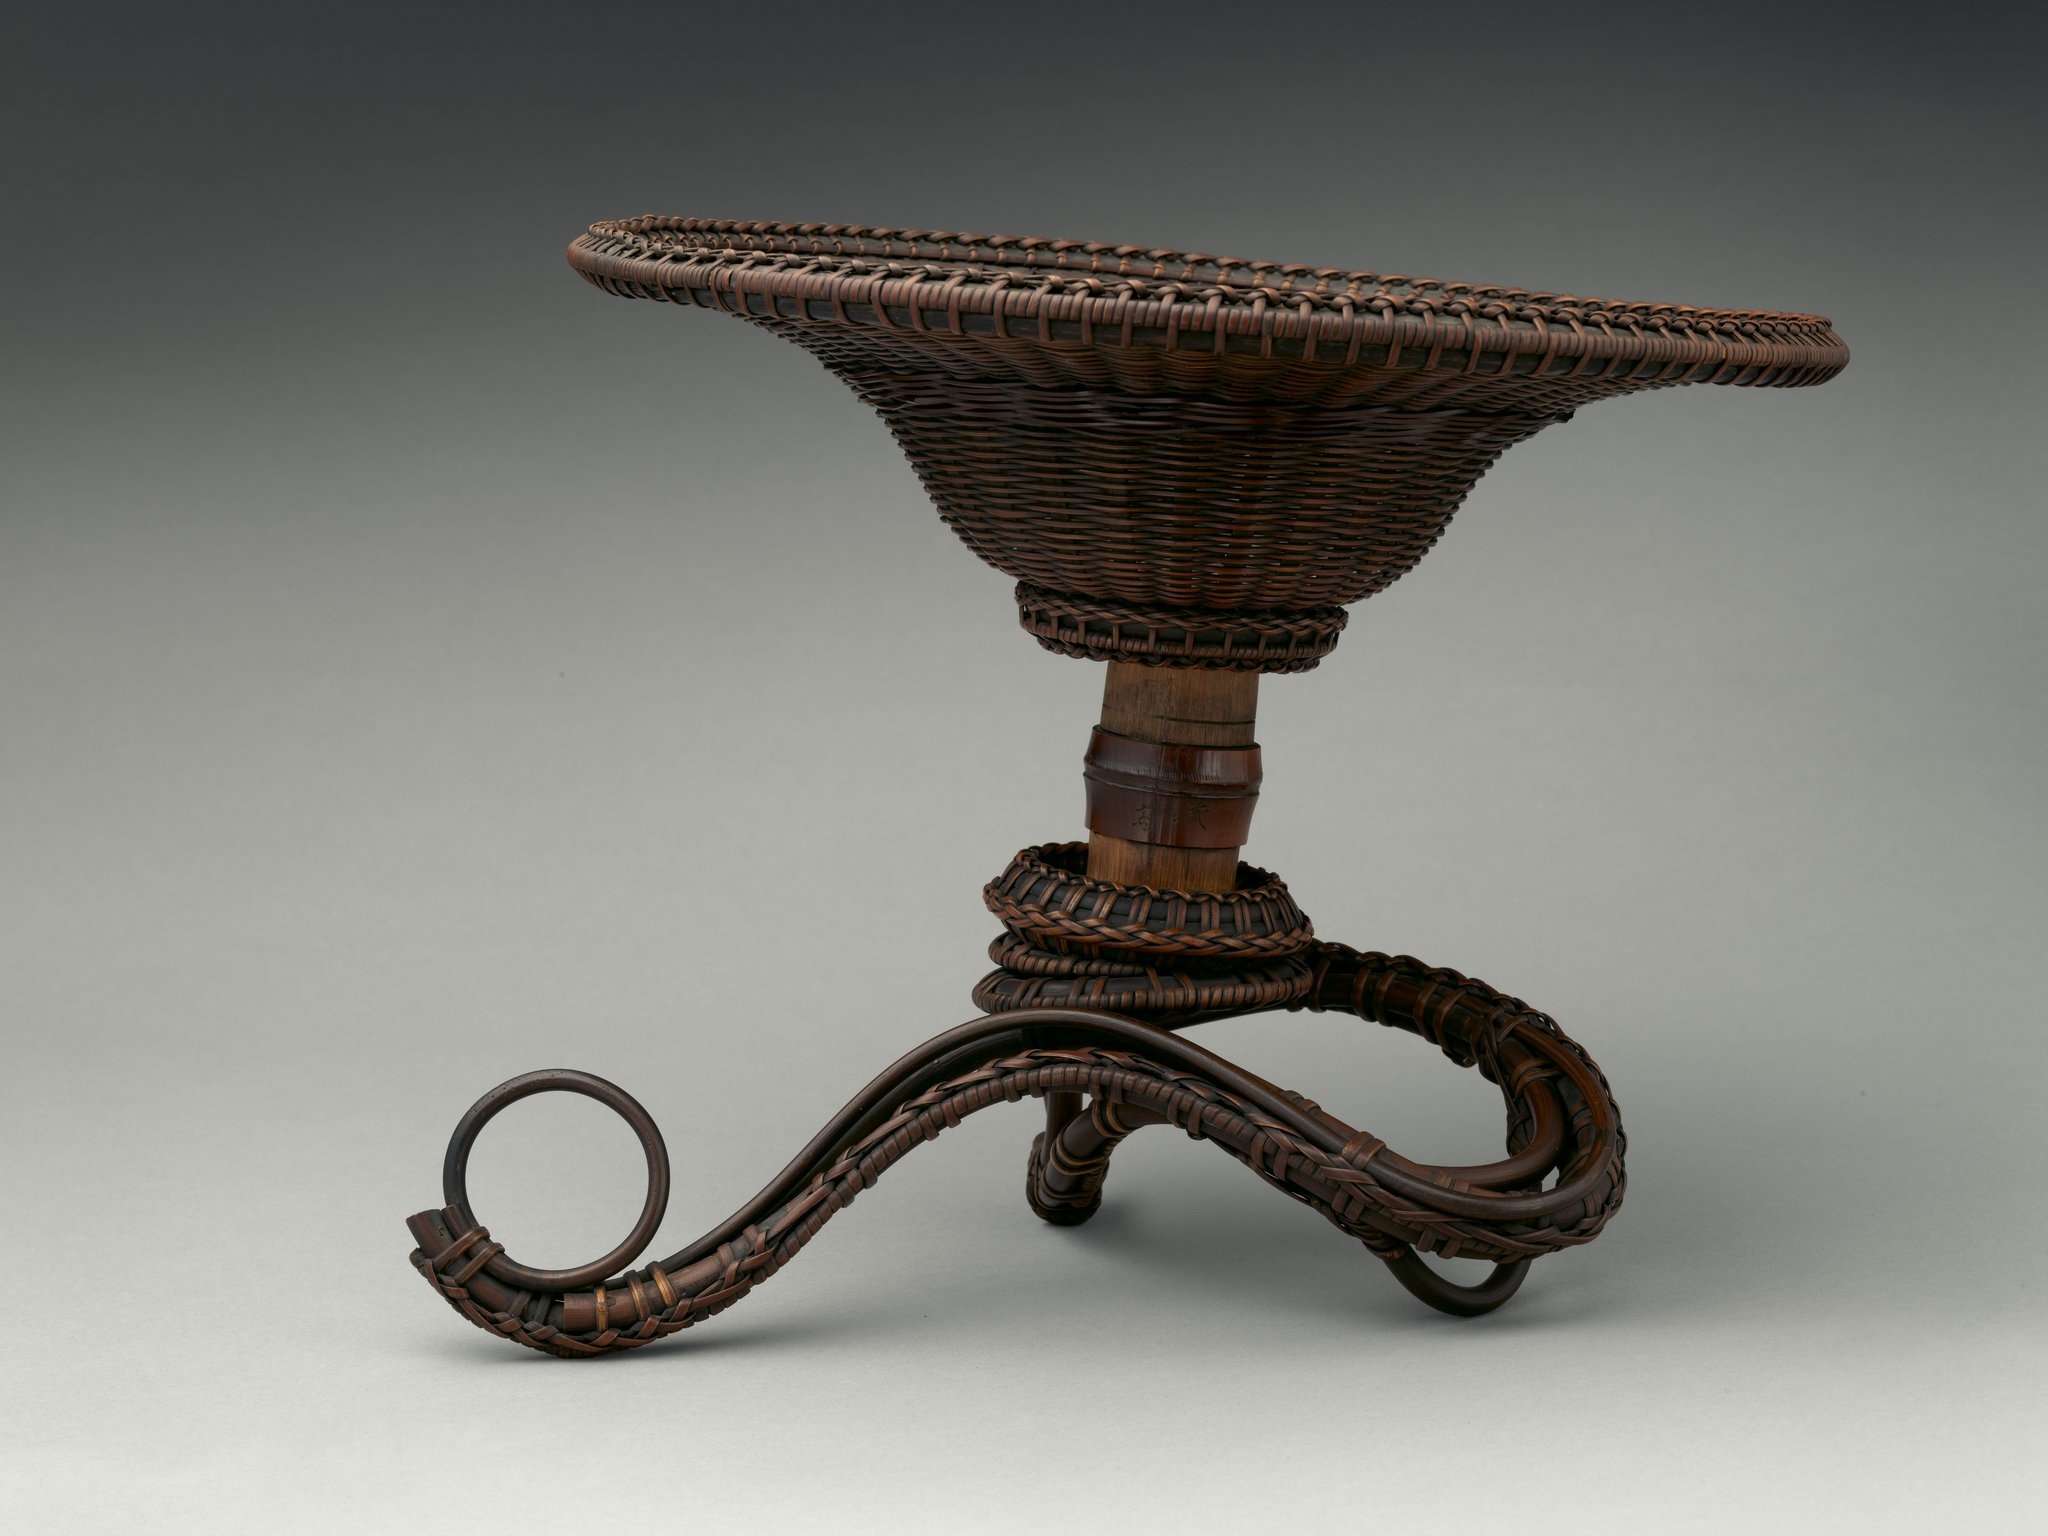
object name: basket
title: Flower Basket (Hanakago) in the Shape of a Flower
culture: japanese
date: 1834-1866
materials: bamboo, rattan